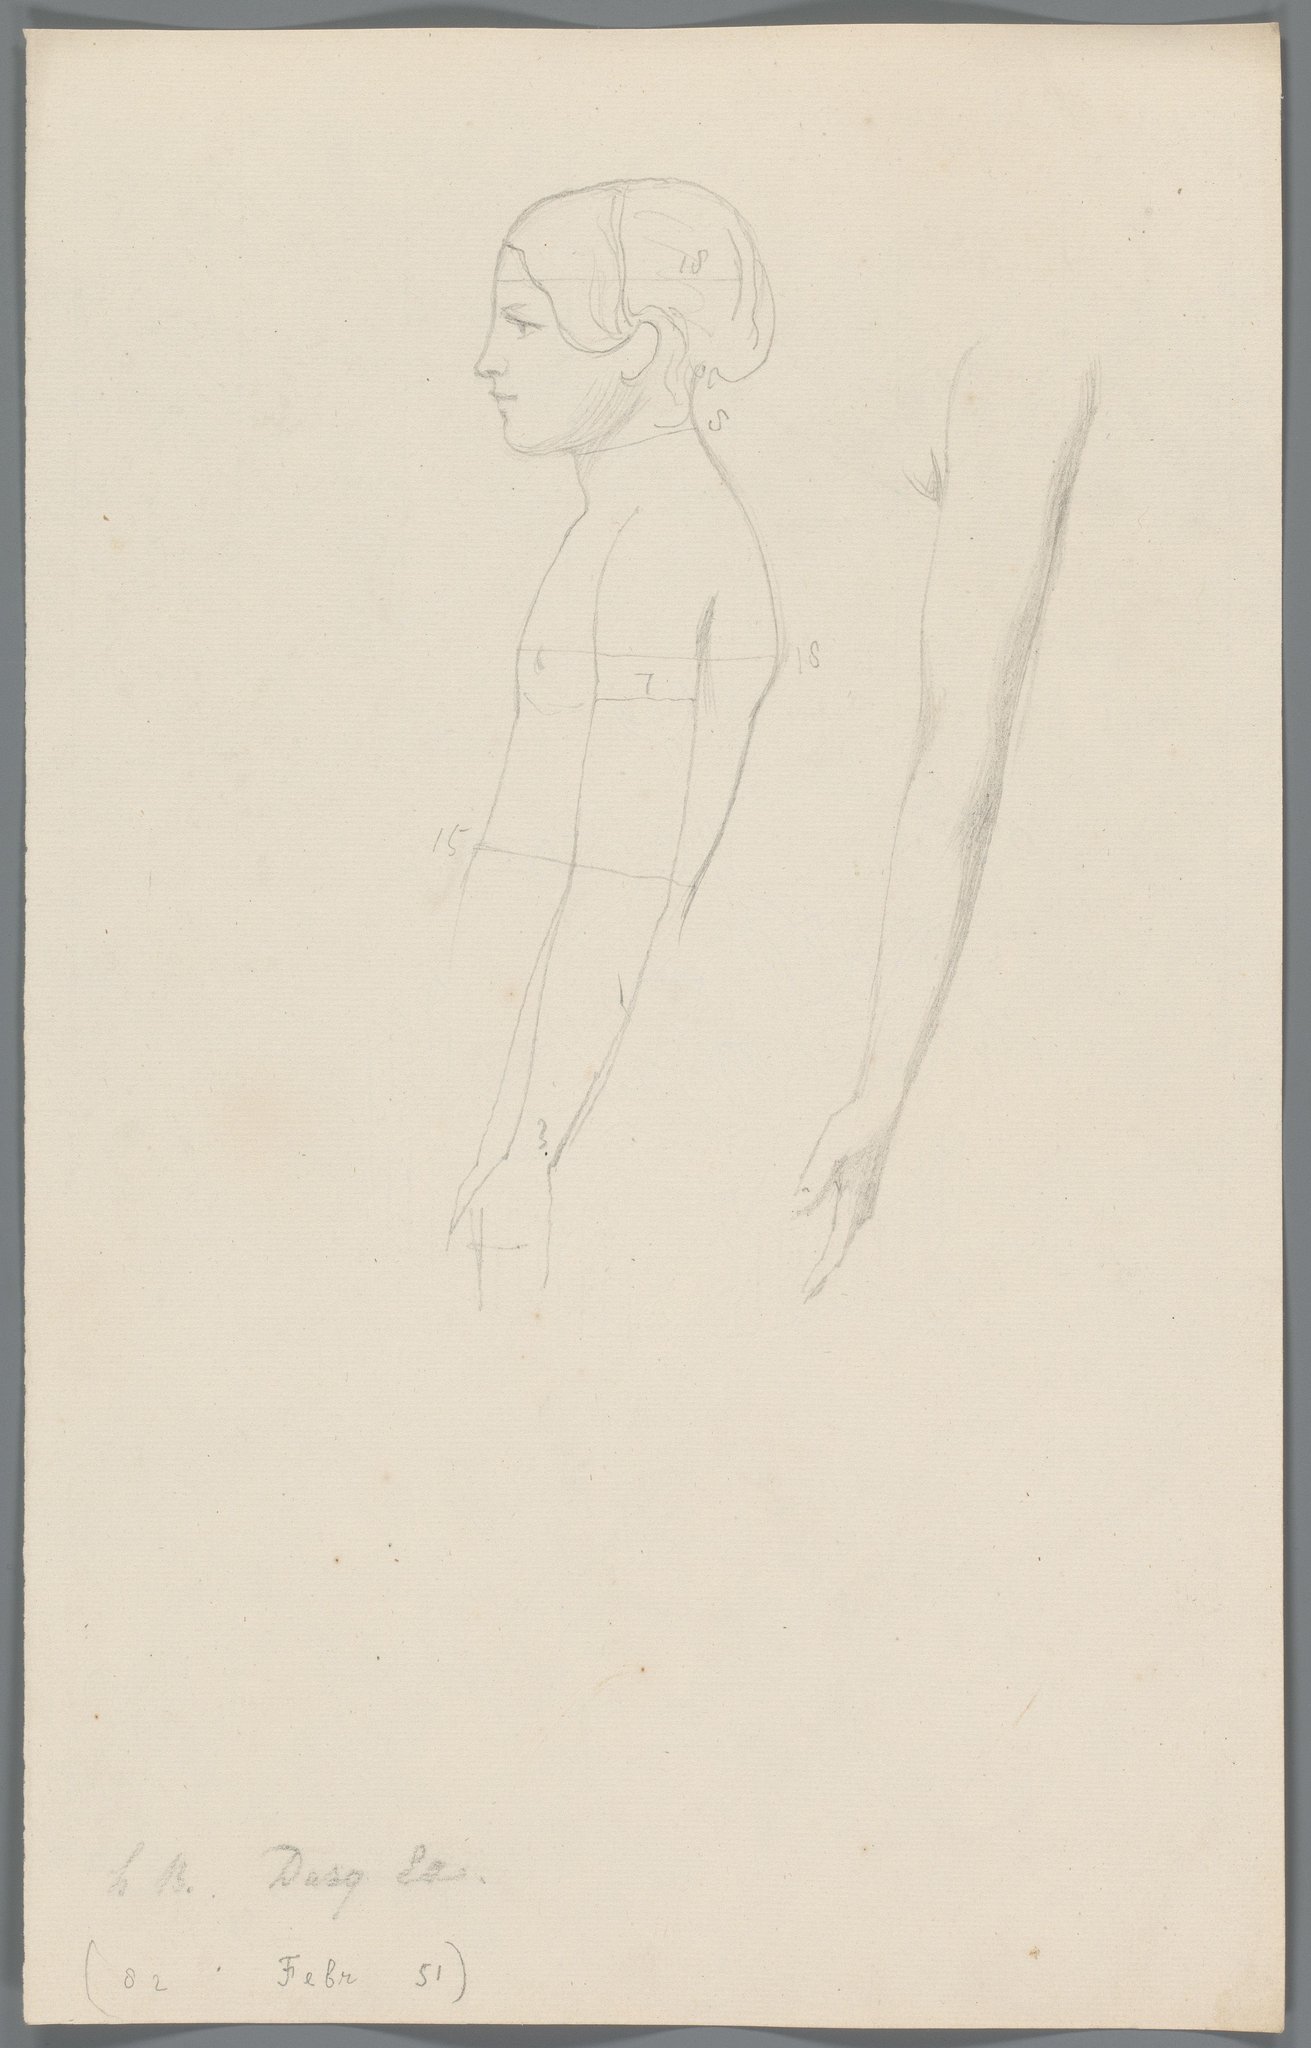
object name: drawing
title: Proportiestudie van een meisje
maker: jacobus everhardus josephus van den berg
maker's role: draughtsman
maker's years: 1802-1861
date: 1851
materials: paper, pencil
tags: standing figure (canon, proportions) - aa - female human figure, child (at home) - aa - girl, postures and gestures of arms and hands